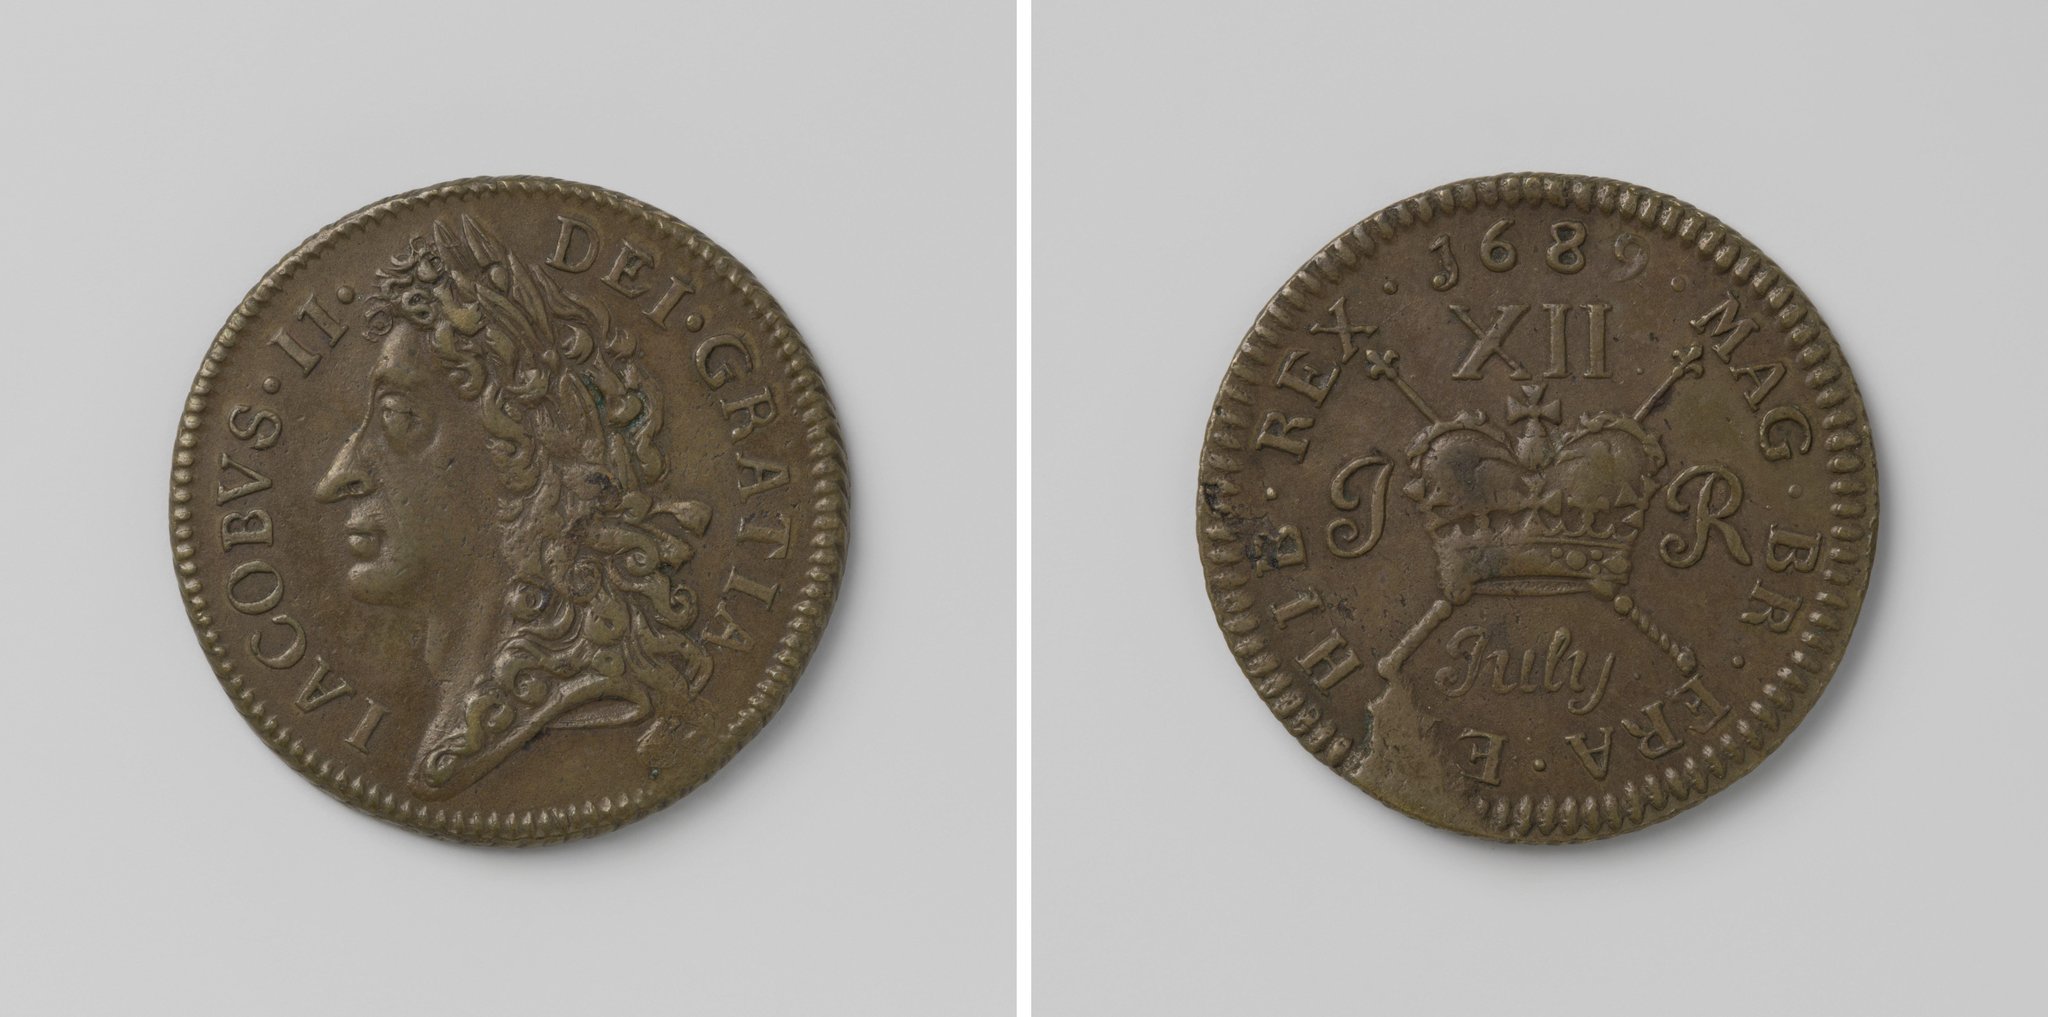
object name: twaalf penny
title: Shilling, noodmunt van Jacobus II, koning van Engeland, uit juli 1689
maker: Anonymous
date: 1607-1689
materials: copper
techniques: striking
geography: ireland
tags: jacobus ii (koning van engeland en schotland)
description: Voorzijde: borststuk man met lauwerkrans binnen omschrift. Keerzijde: kroon, waardoor twee gekruiste scepters steken tussen monogram van letters J en R; boven kroon Romeinse cijfer XXX, onder kroon opschrift "July." binnen omschrift